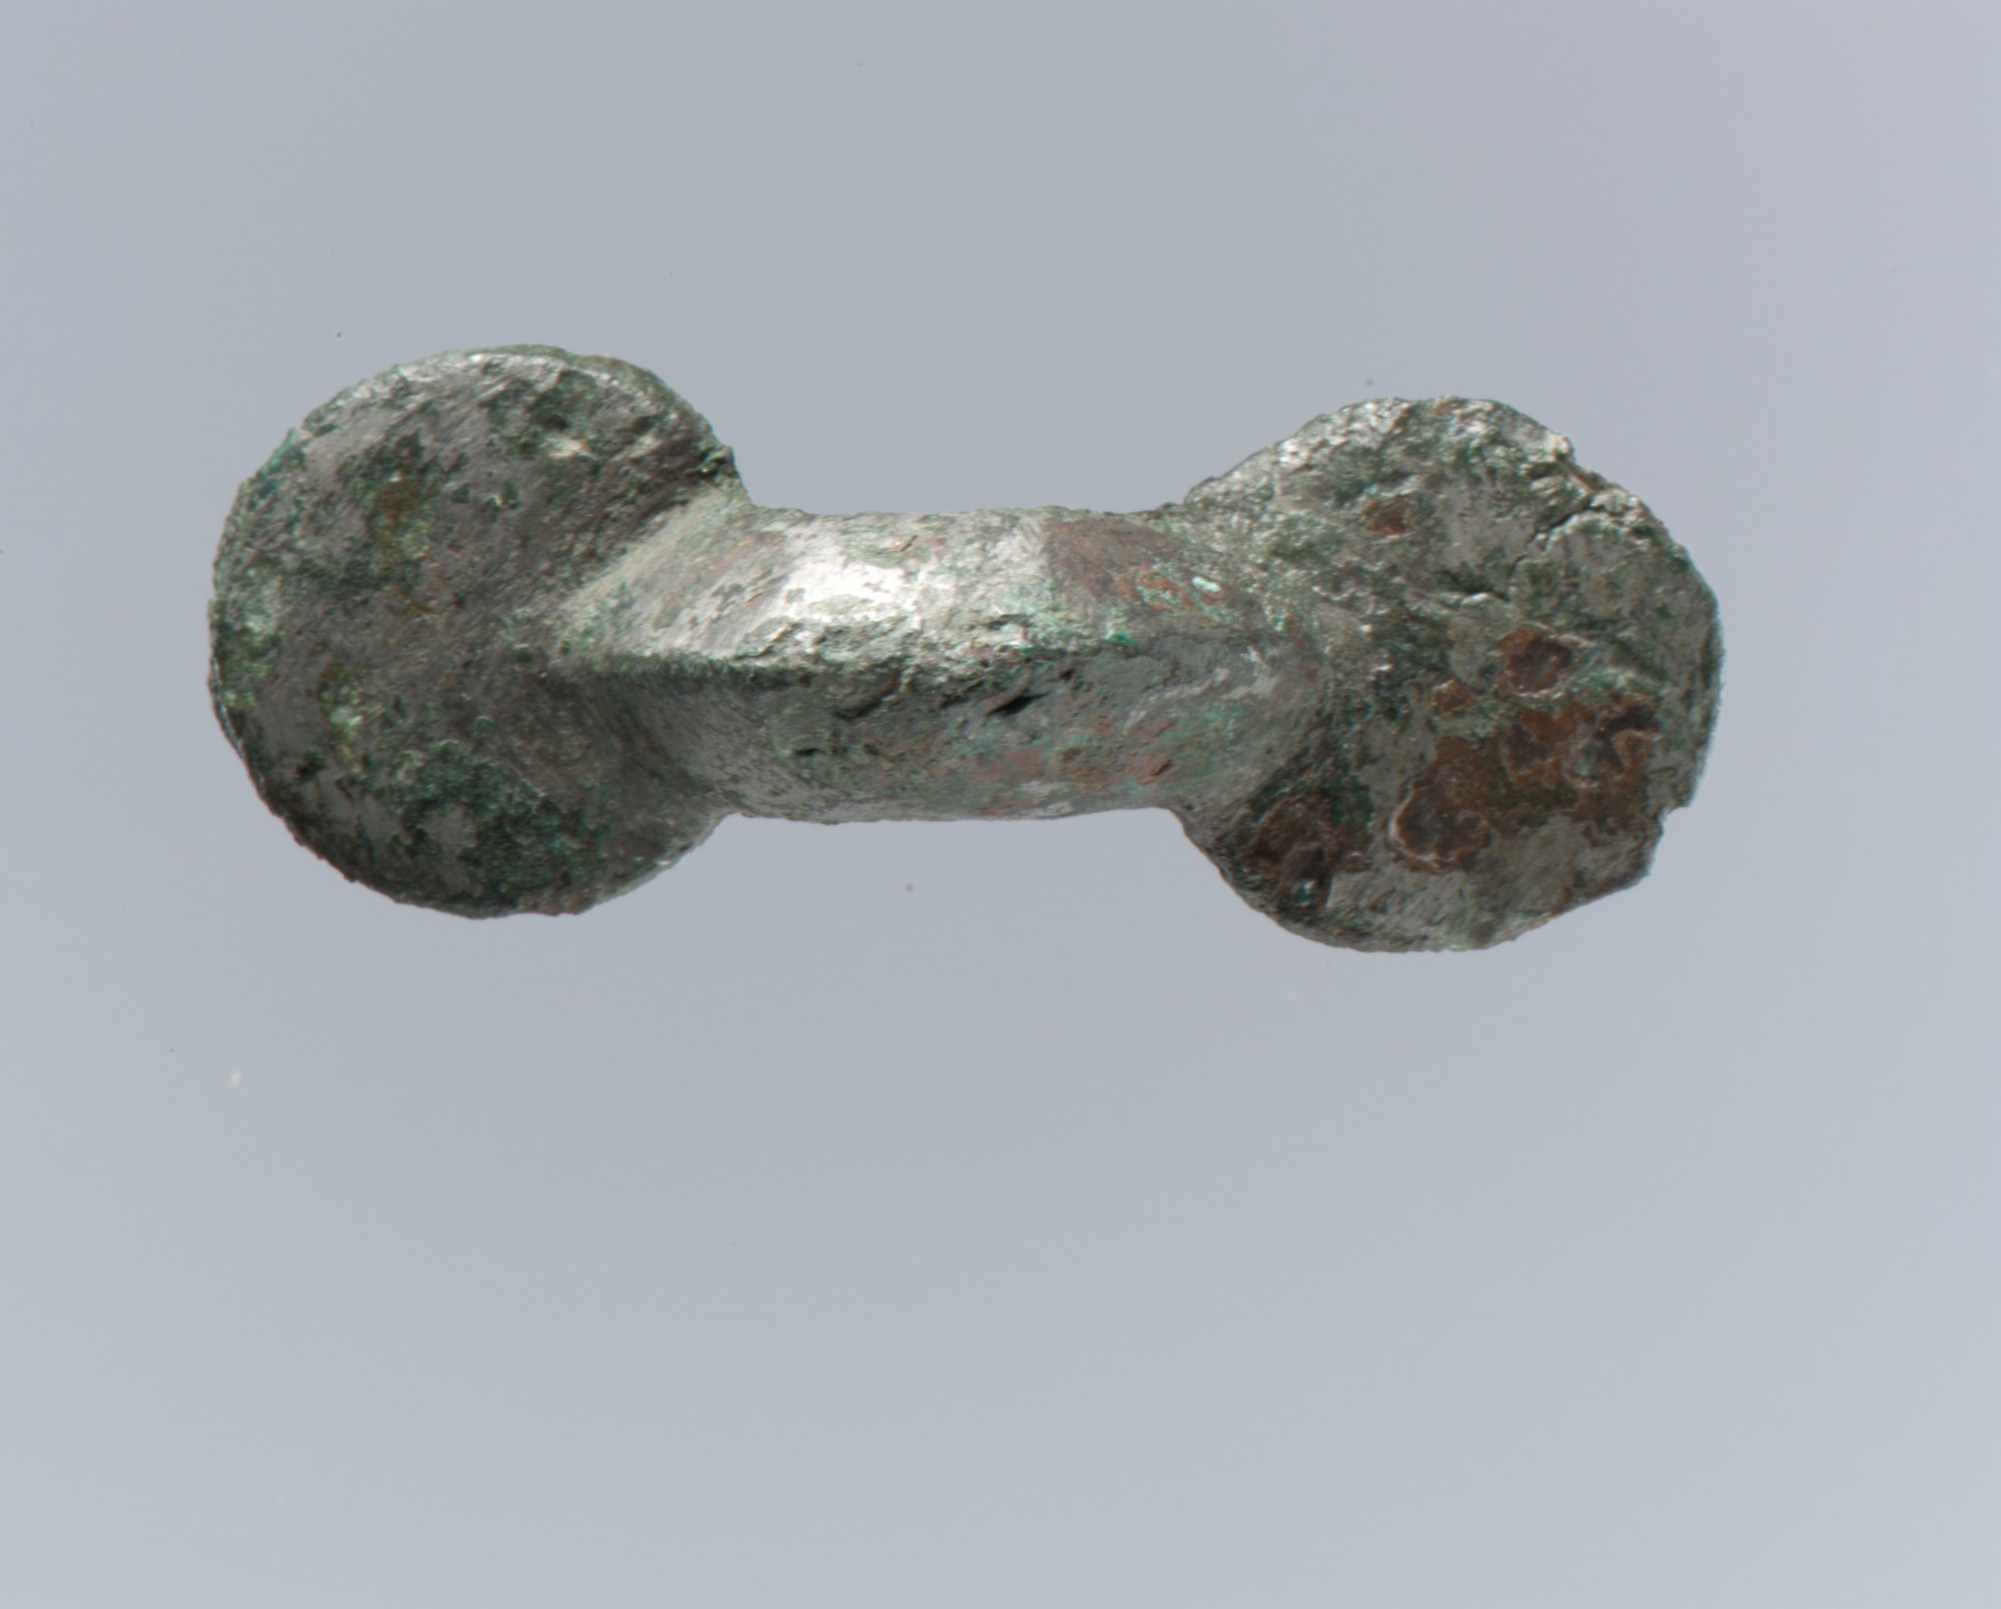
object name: brooch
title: Equal-Arm Brooch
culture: frankish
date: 650-750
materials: copper alloy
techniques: silvered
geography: germany